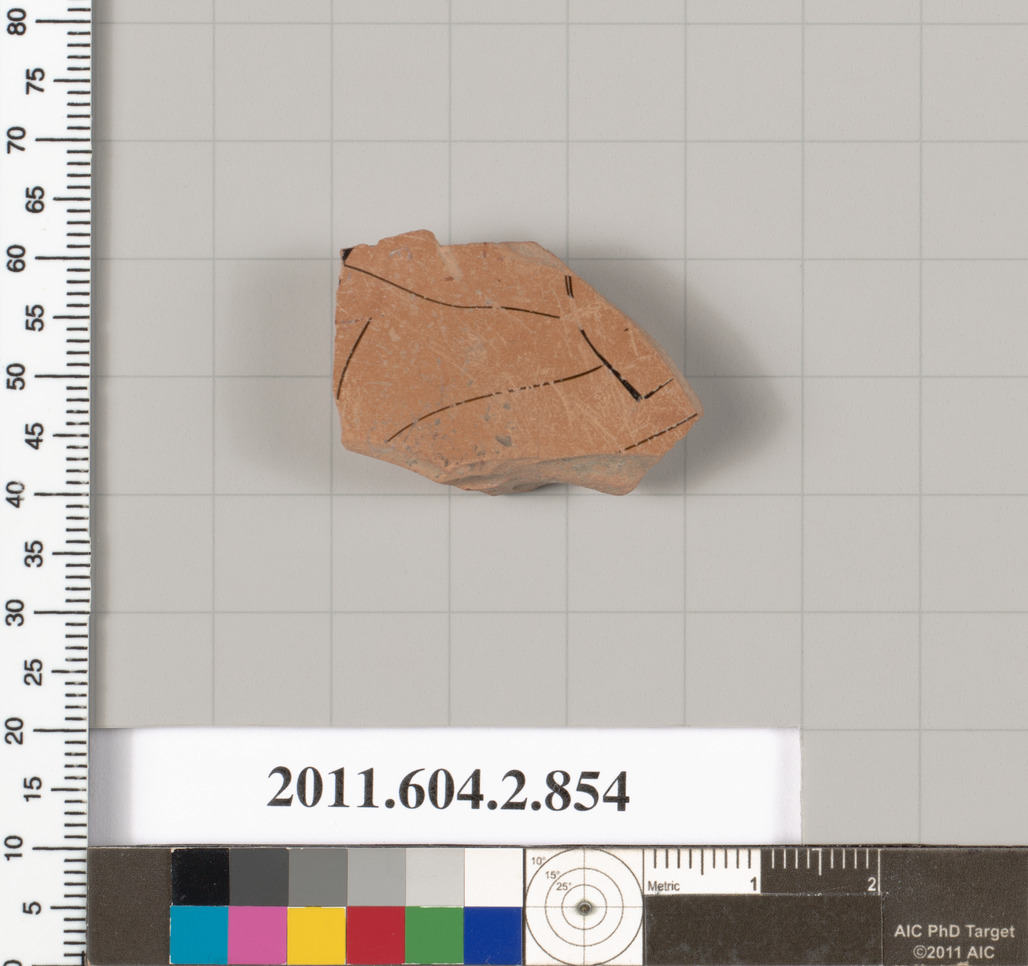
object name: bell krater fragment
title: Terracotta fragment of a bell-krater (bowl for mixing wine and water)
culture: greek, attic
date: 467-435 BCE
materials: terracotta